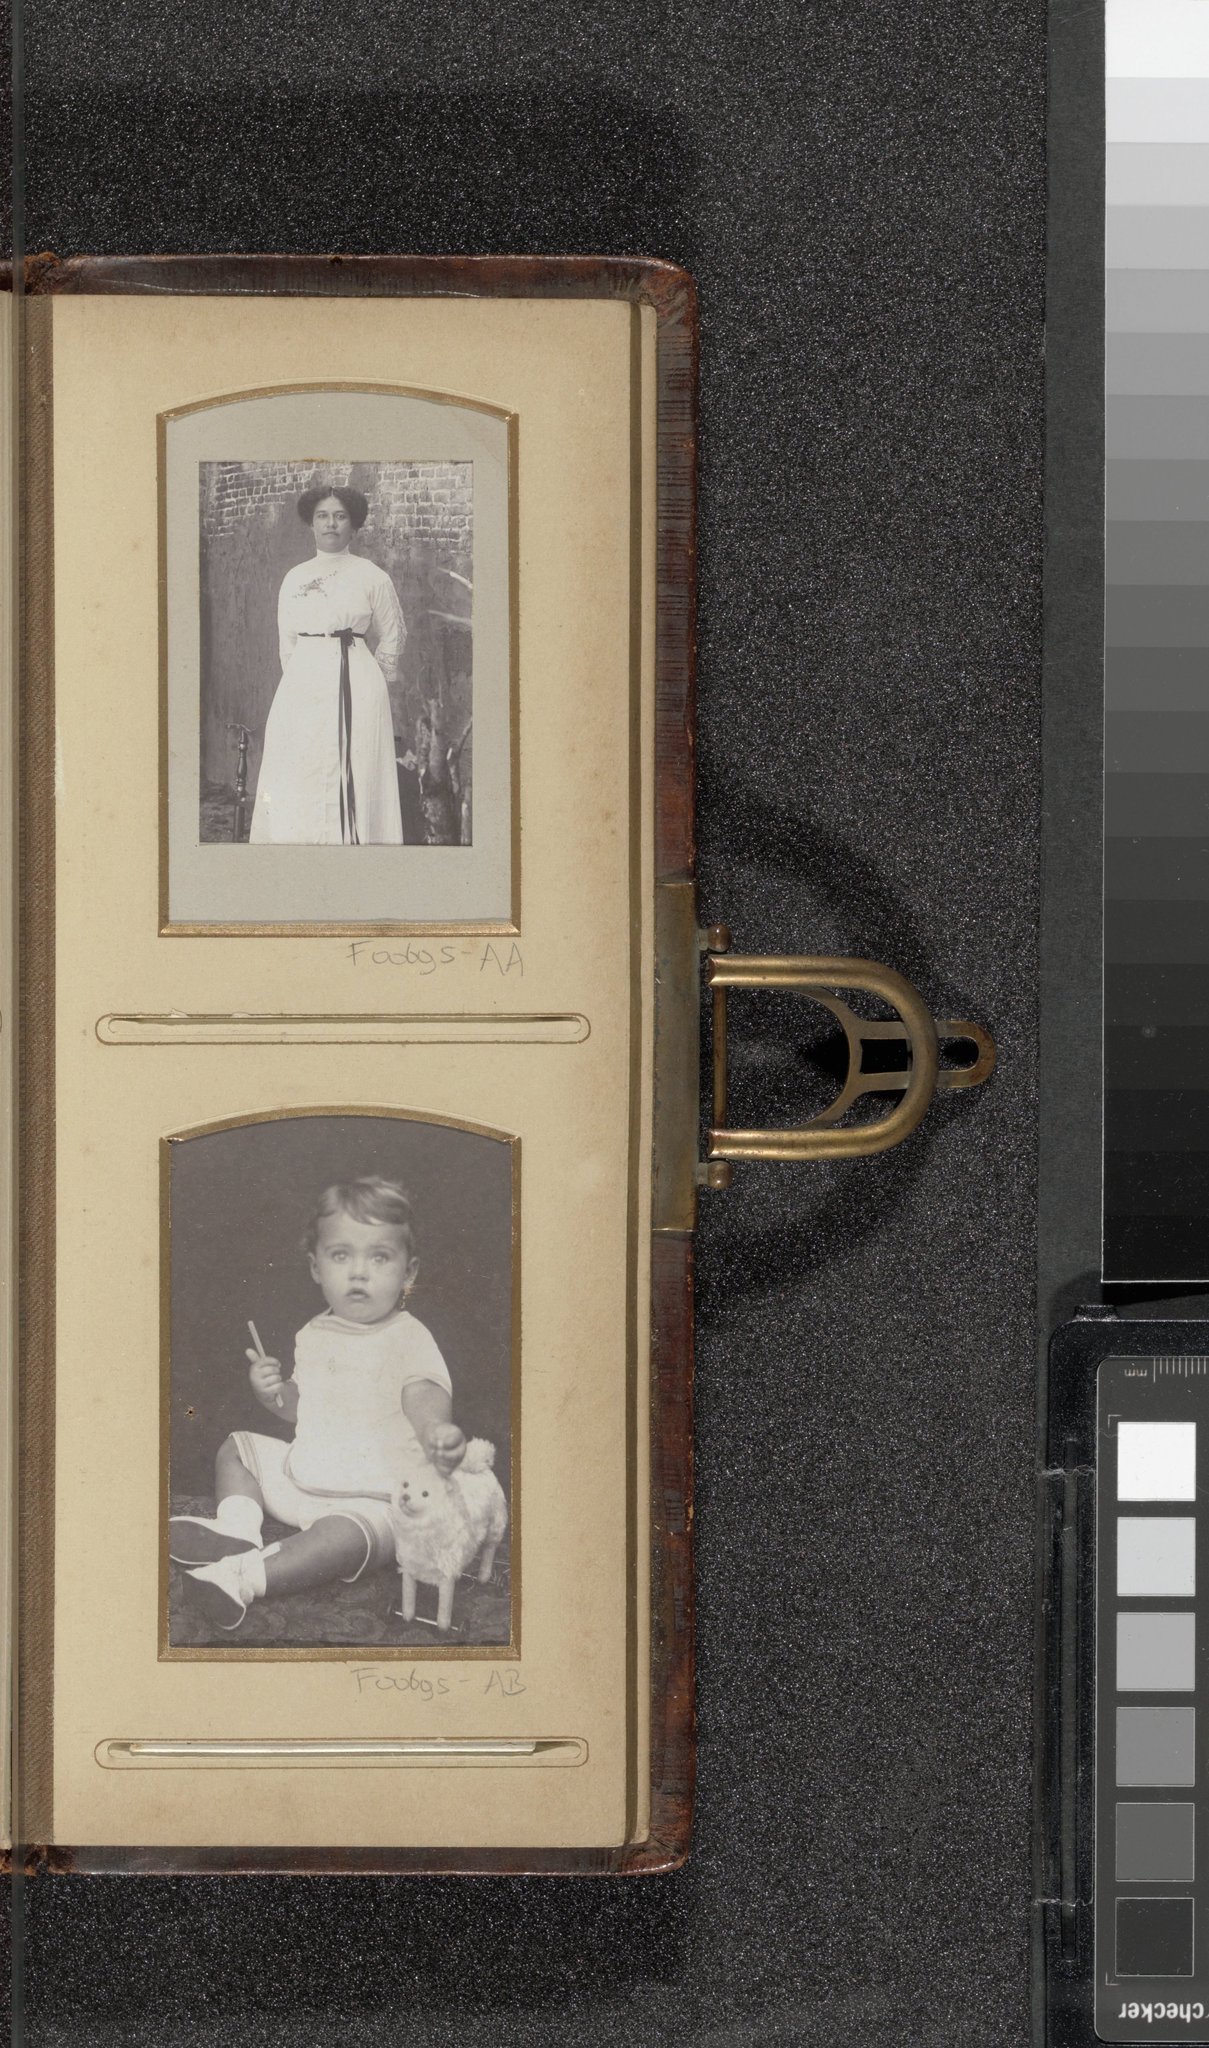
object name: photograph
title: Portret van een kind met een speelgoedhond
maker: augusta curiel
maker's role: fotograaf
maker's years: 1873-1937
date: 1910-1920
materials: cardboard, paper, photographic support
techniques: gelatin silver print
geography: paramaribo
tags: playing toddler; child amusing itself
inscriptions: address: ‘Paramaribo’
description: Onderdeel van Album met 28 foto's van een Nederlands-Surinaamse familie.